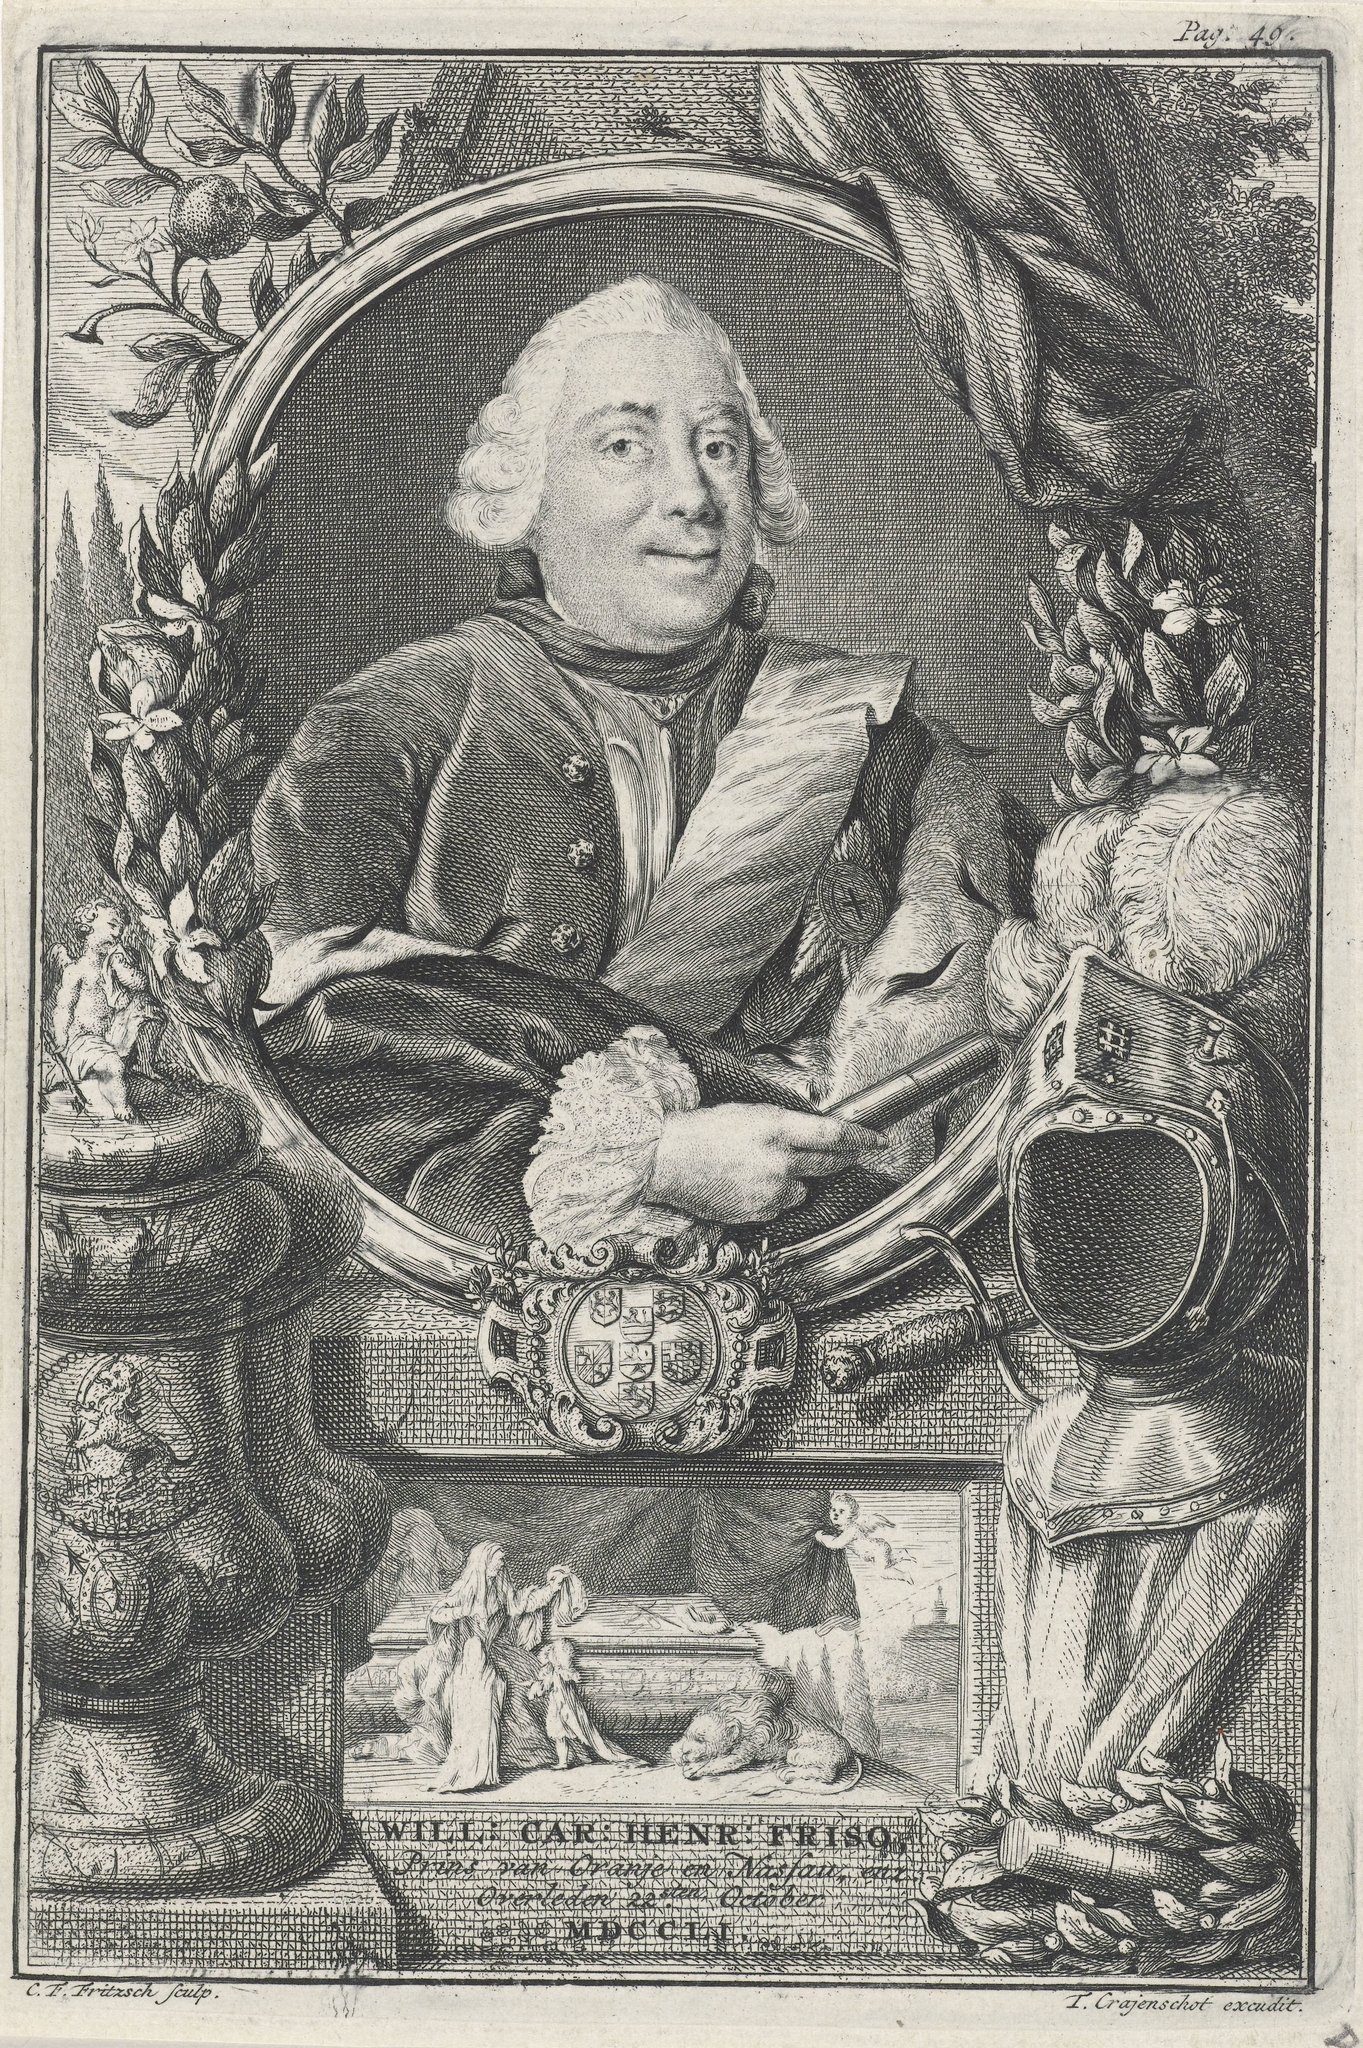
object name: print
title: Portret van Willem IV, prins van Oranje-Nassau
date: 1751-1800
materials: paper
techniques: etching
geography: amsterdam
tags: the hague, willem iv (prins van oranje-nassau)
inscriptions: collector's mark: Lugt 2228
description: Portretbuste in ovaal van Willem IV, prins van Oranje-Nassau, commandostaf in de hand. Het ovaal is versierd met appeltjes van Oranje en plantentakken met bloemen. Onderin de ovale lijst prijkt een cartouche met diverse wapenschilden. Het portret rust op een sokkel waarop een reliëf met de beeltenis van een grafmonument prijkt. Links op de voorgrond staat een siervaas, versierd met de Nederlandse leeuw met een bundel pijlen in zijn klauwen, bovenop de vaas zit een rouwende putto. Rechts van de sokkel staat een gepluimde helm opgesteld. Prent rechtsboven gemerkt: Pag. 49.